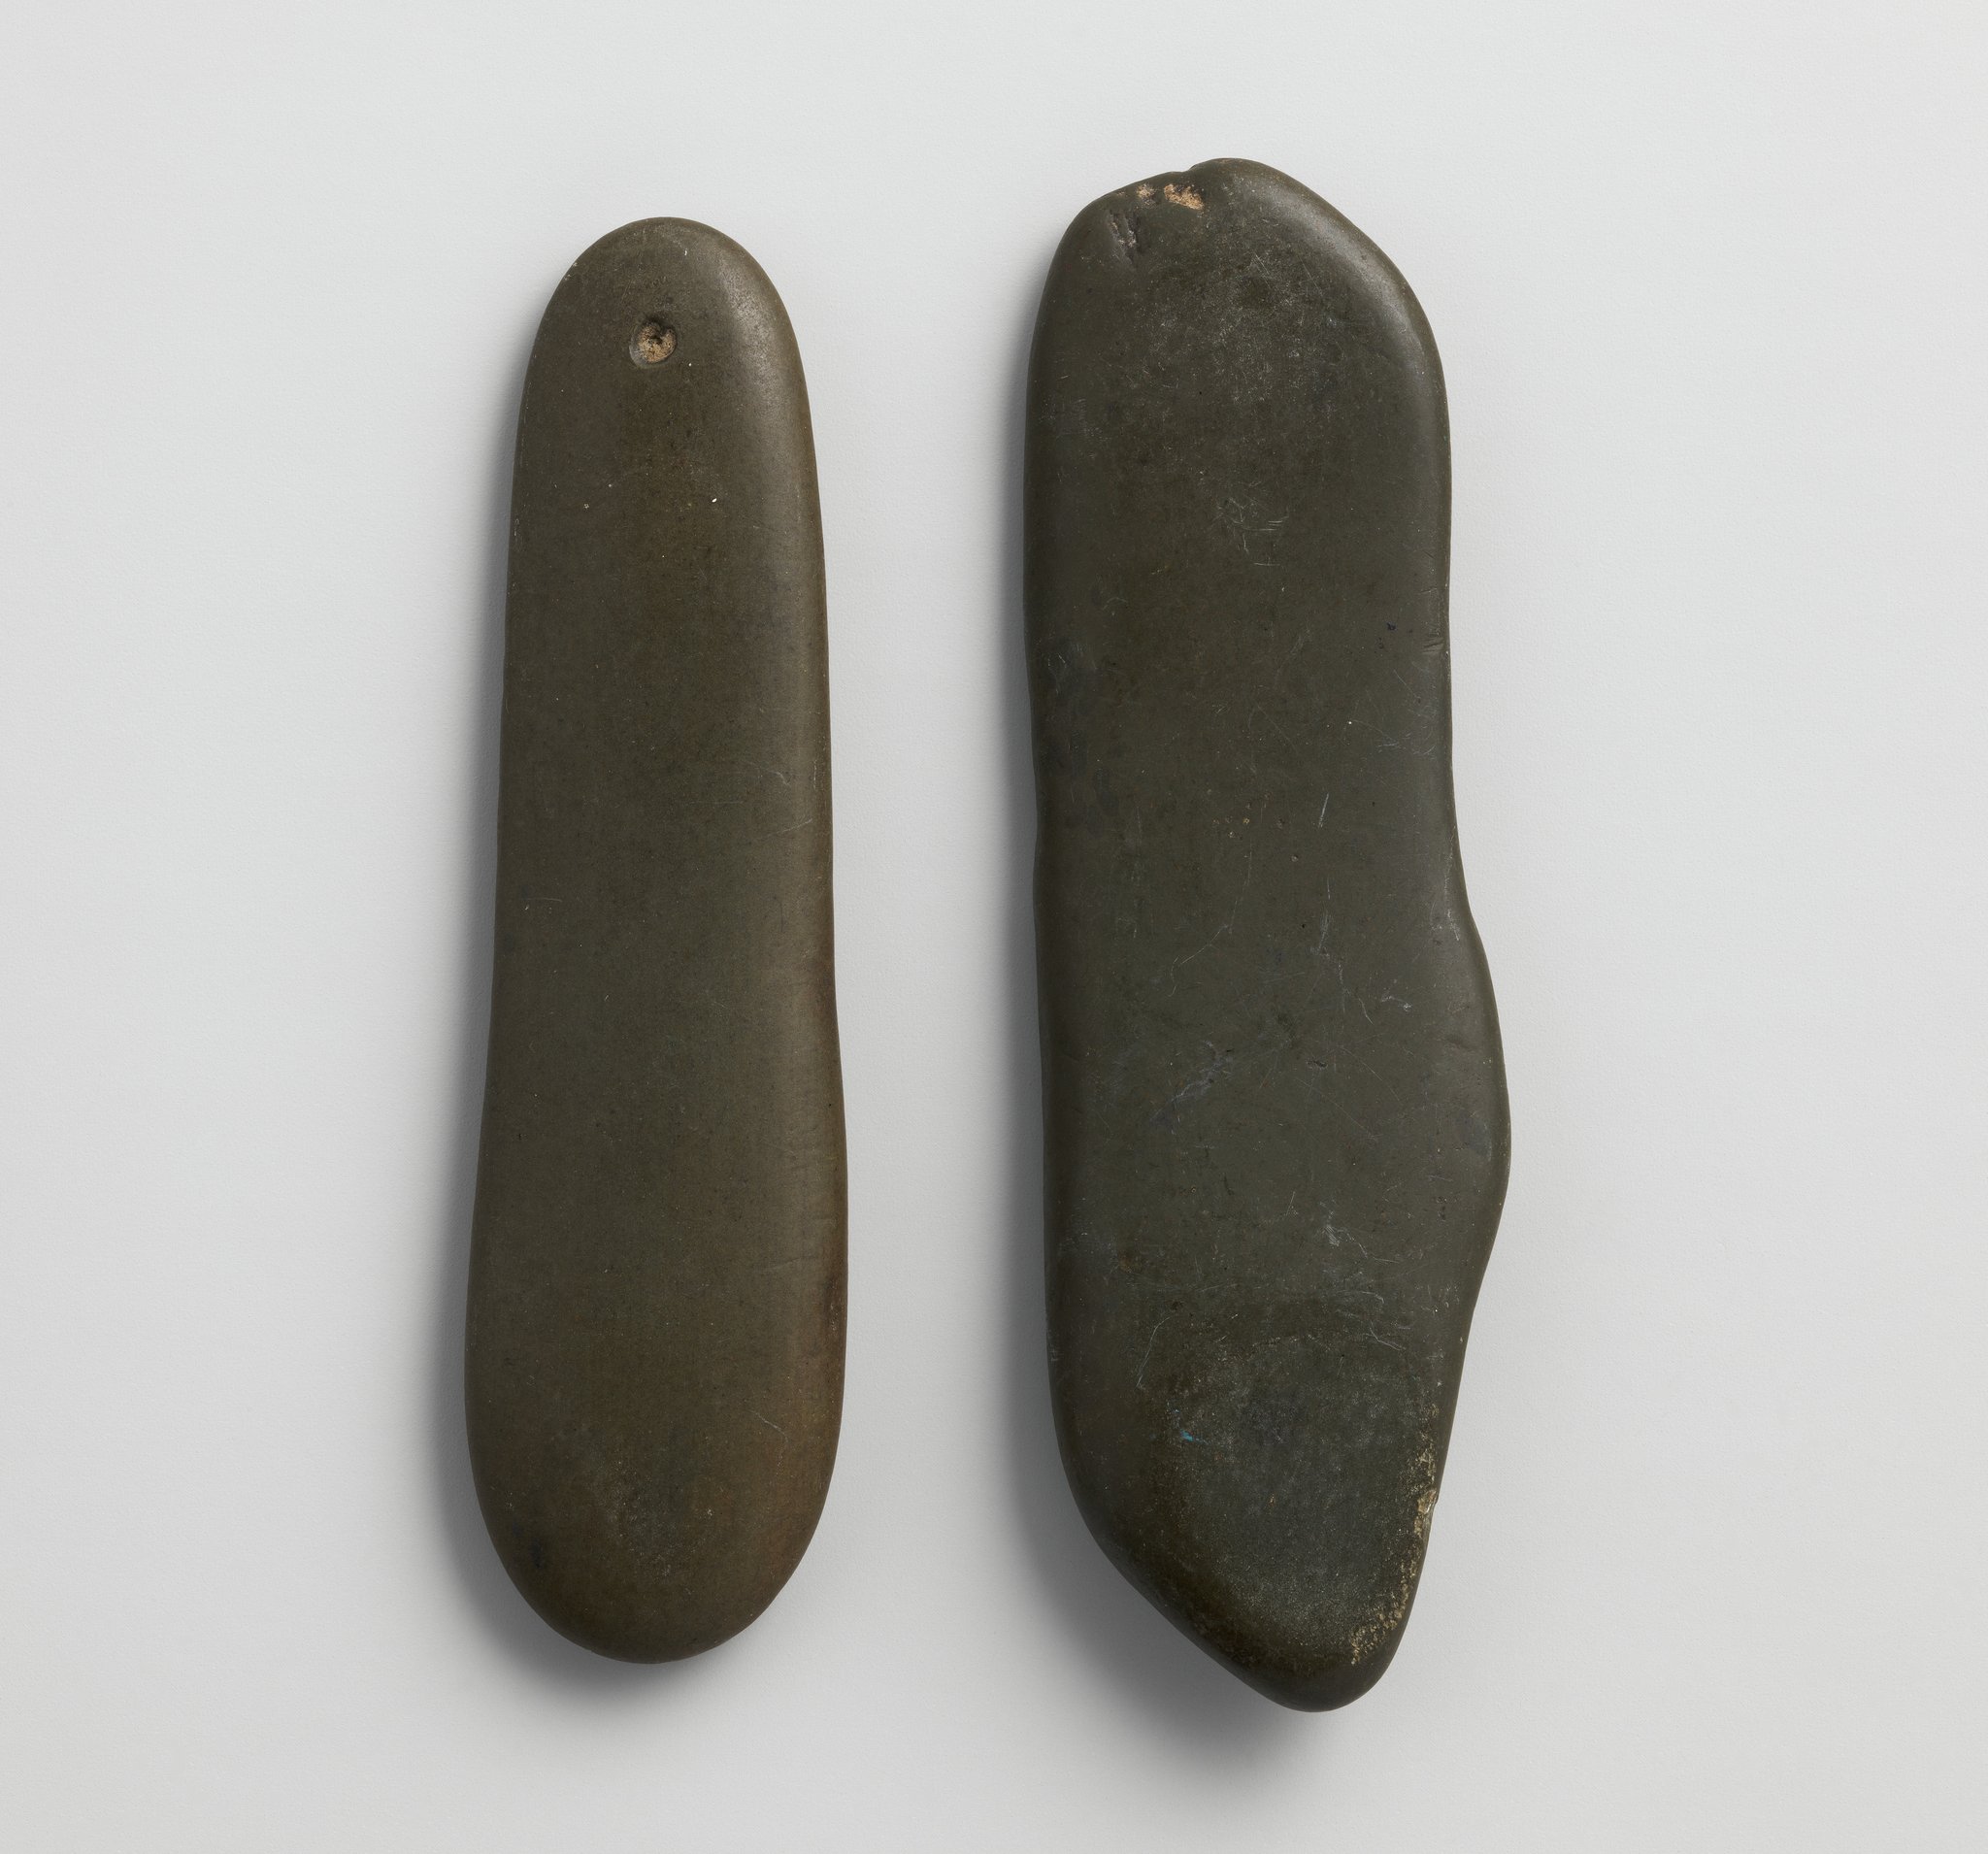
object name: qairaq stone castanets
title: Qairaq (stone castanets)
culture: afghan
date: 1934-1966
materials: stone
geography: afghanistan